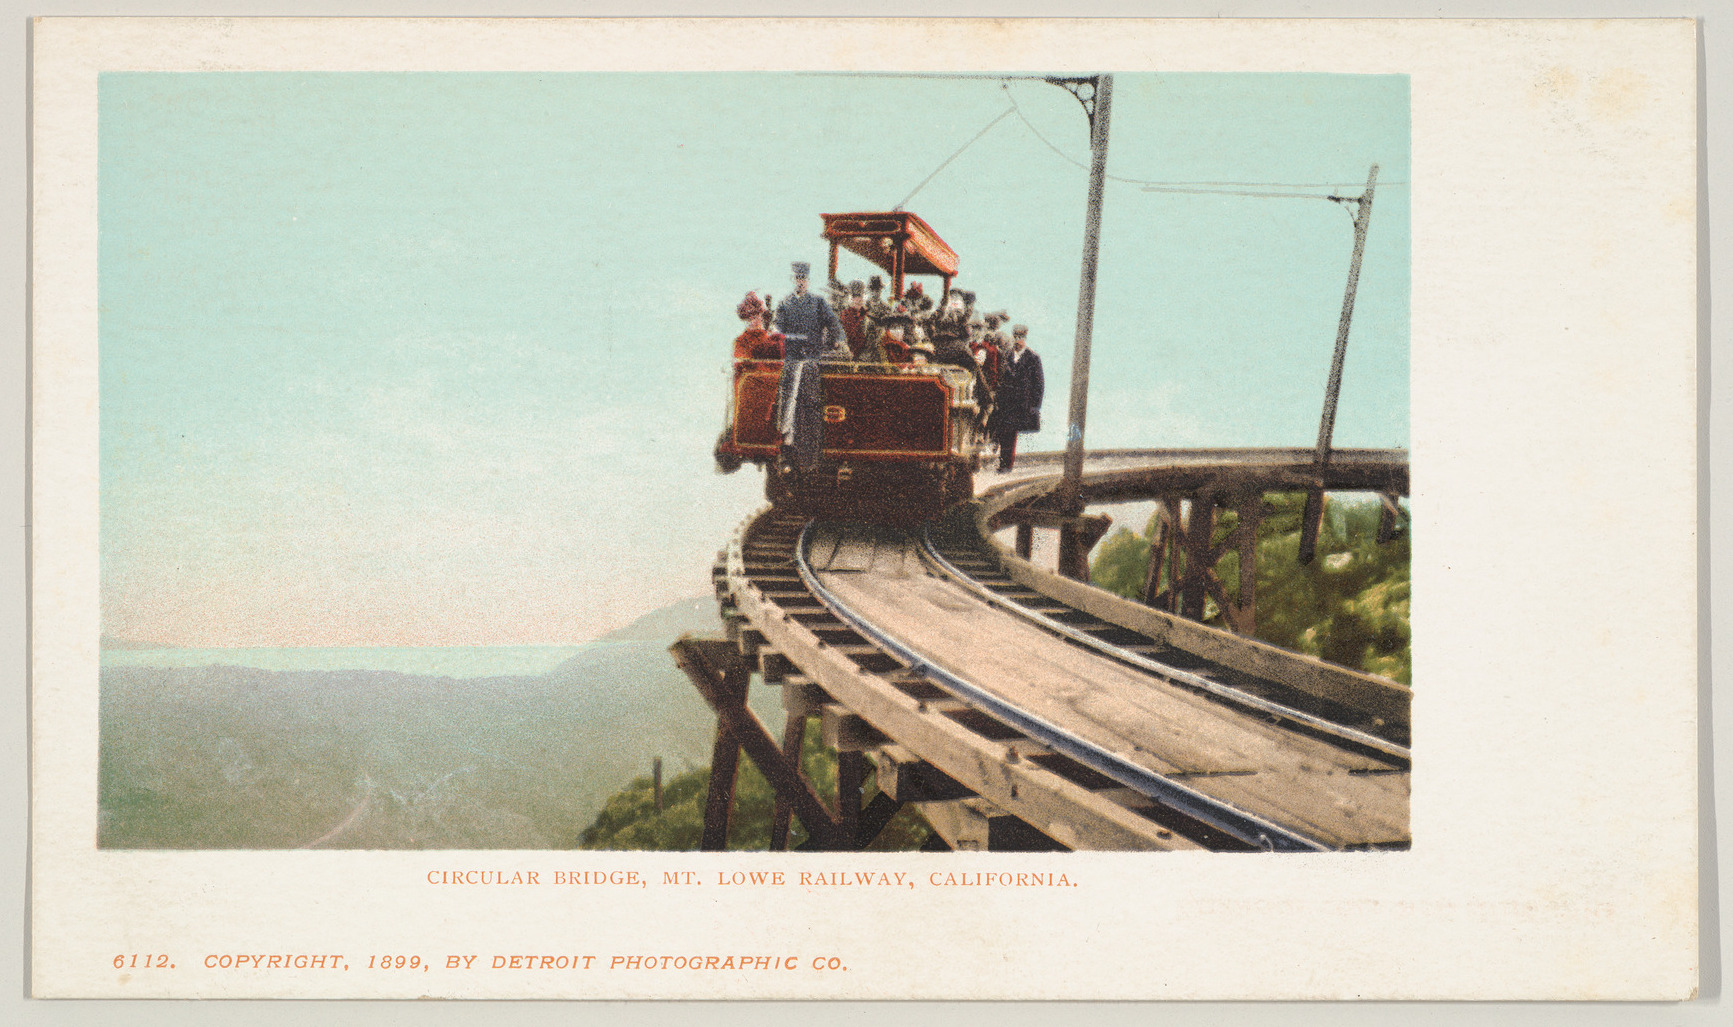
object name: print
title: Circular Bridge, Mt. Lowe Railway, California, No. 6112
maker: detroit publishing company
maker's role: publisher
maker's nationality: american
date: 1899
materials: photographic process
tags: human figures,bridges,railways,trains